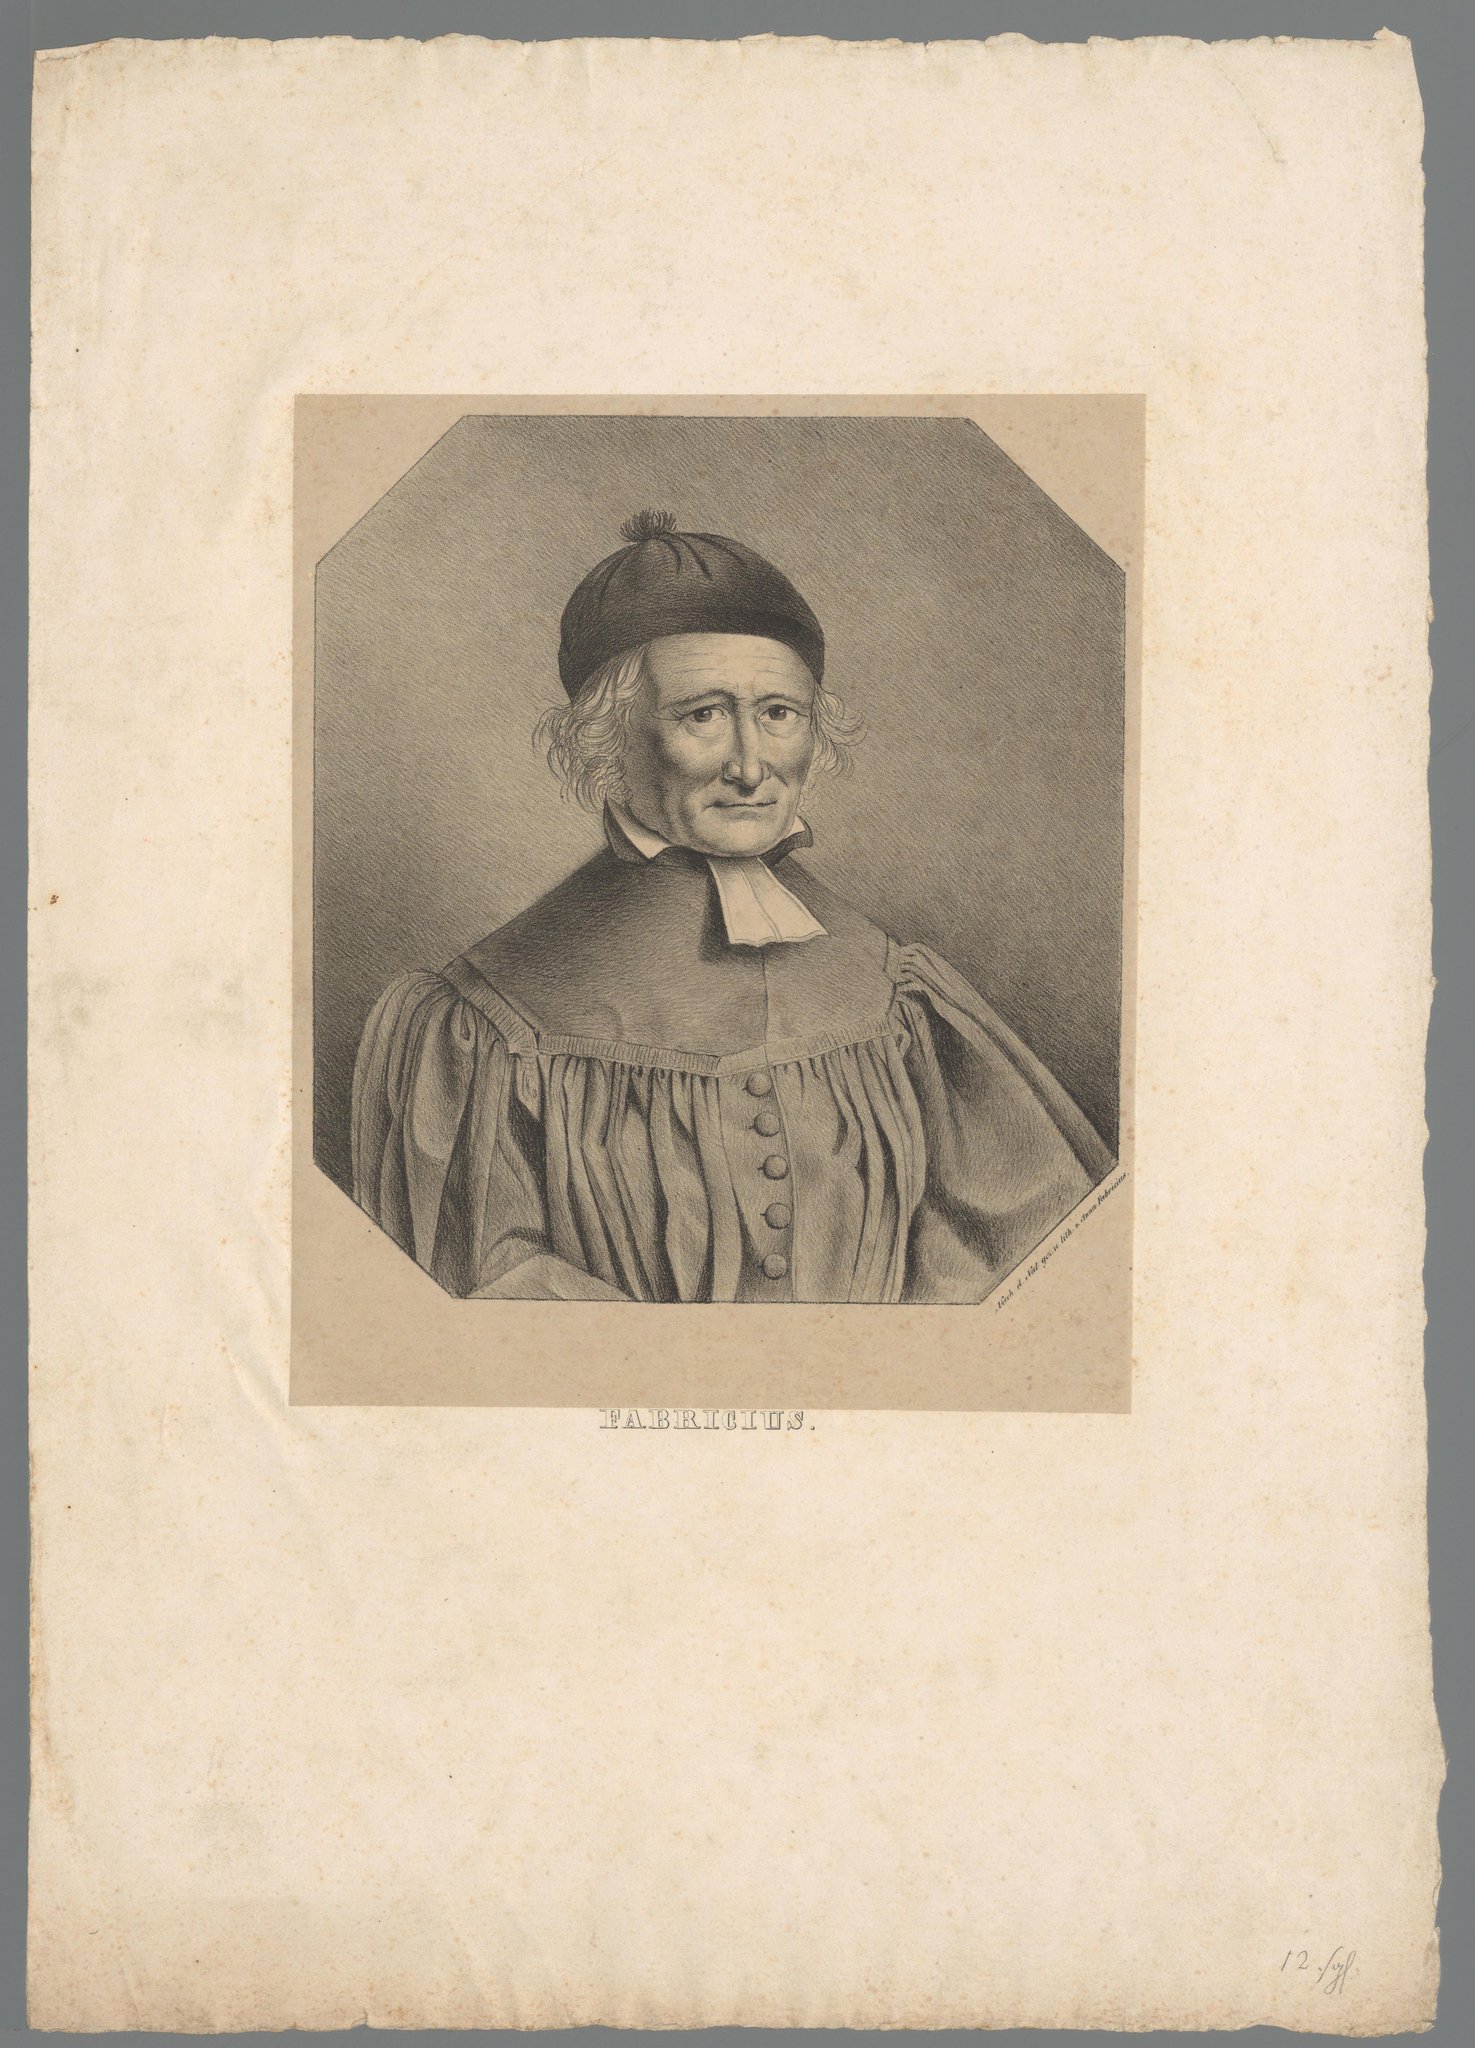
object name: print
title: Portret van Fabricius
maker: anna fabricius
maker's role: print maker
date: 1830-1870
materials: paper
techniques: lithograph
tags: historical persons not known by name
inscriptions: collector's mark: Lugt 2228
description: Portret van een verder onbekende oude man of vrouw, met de naam Fabricius.